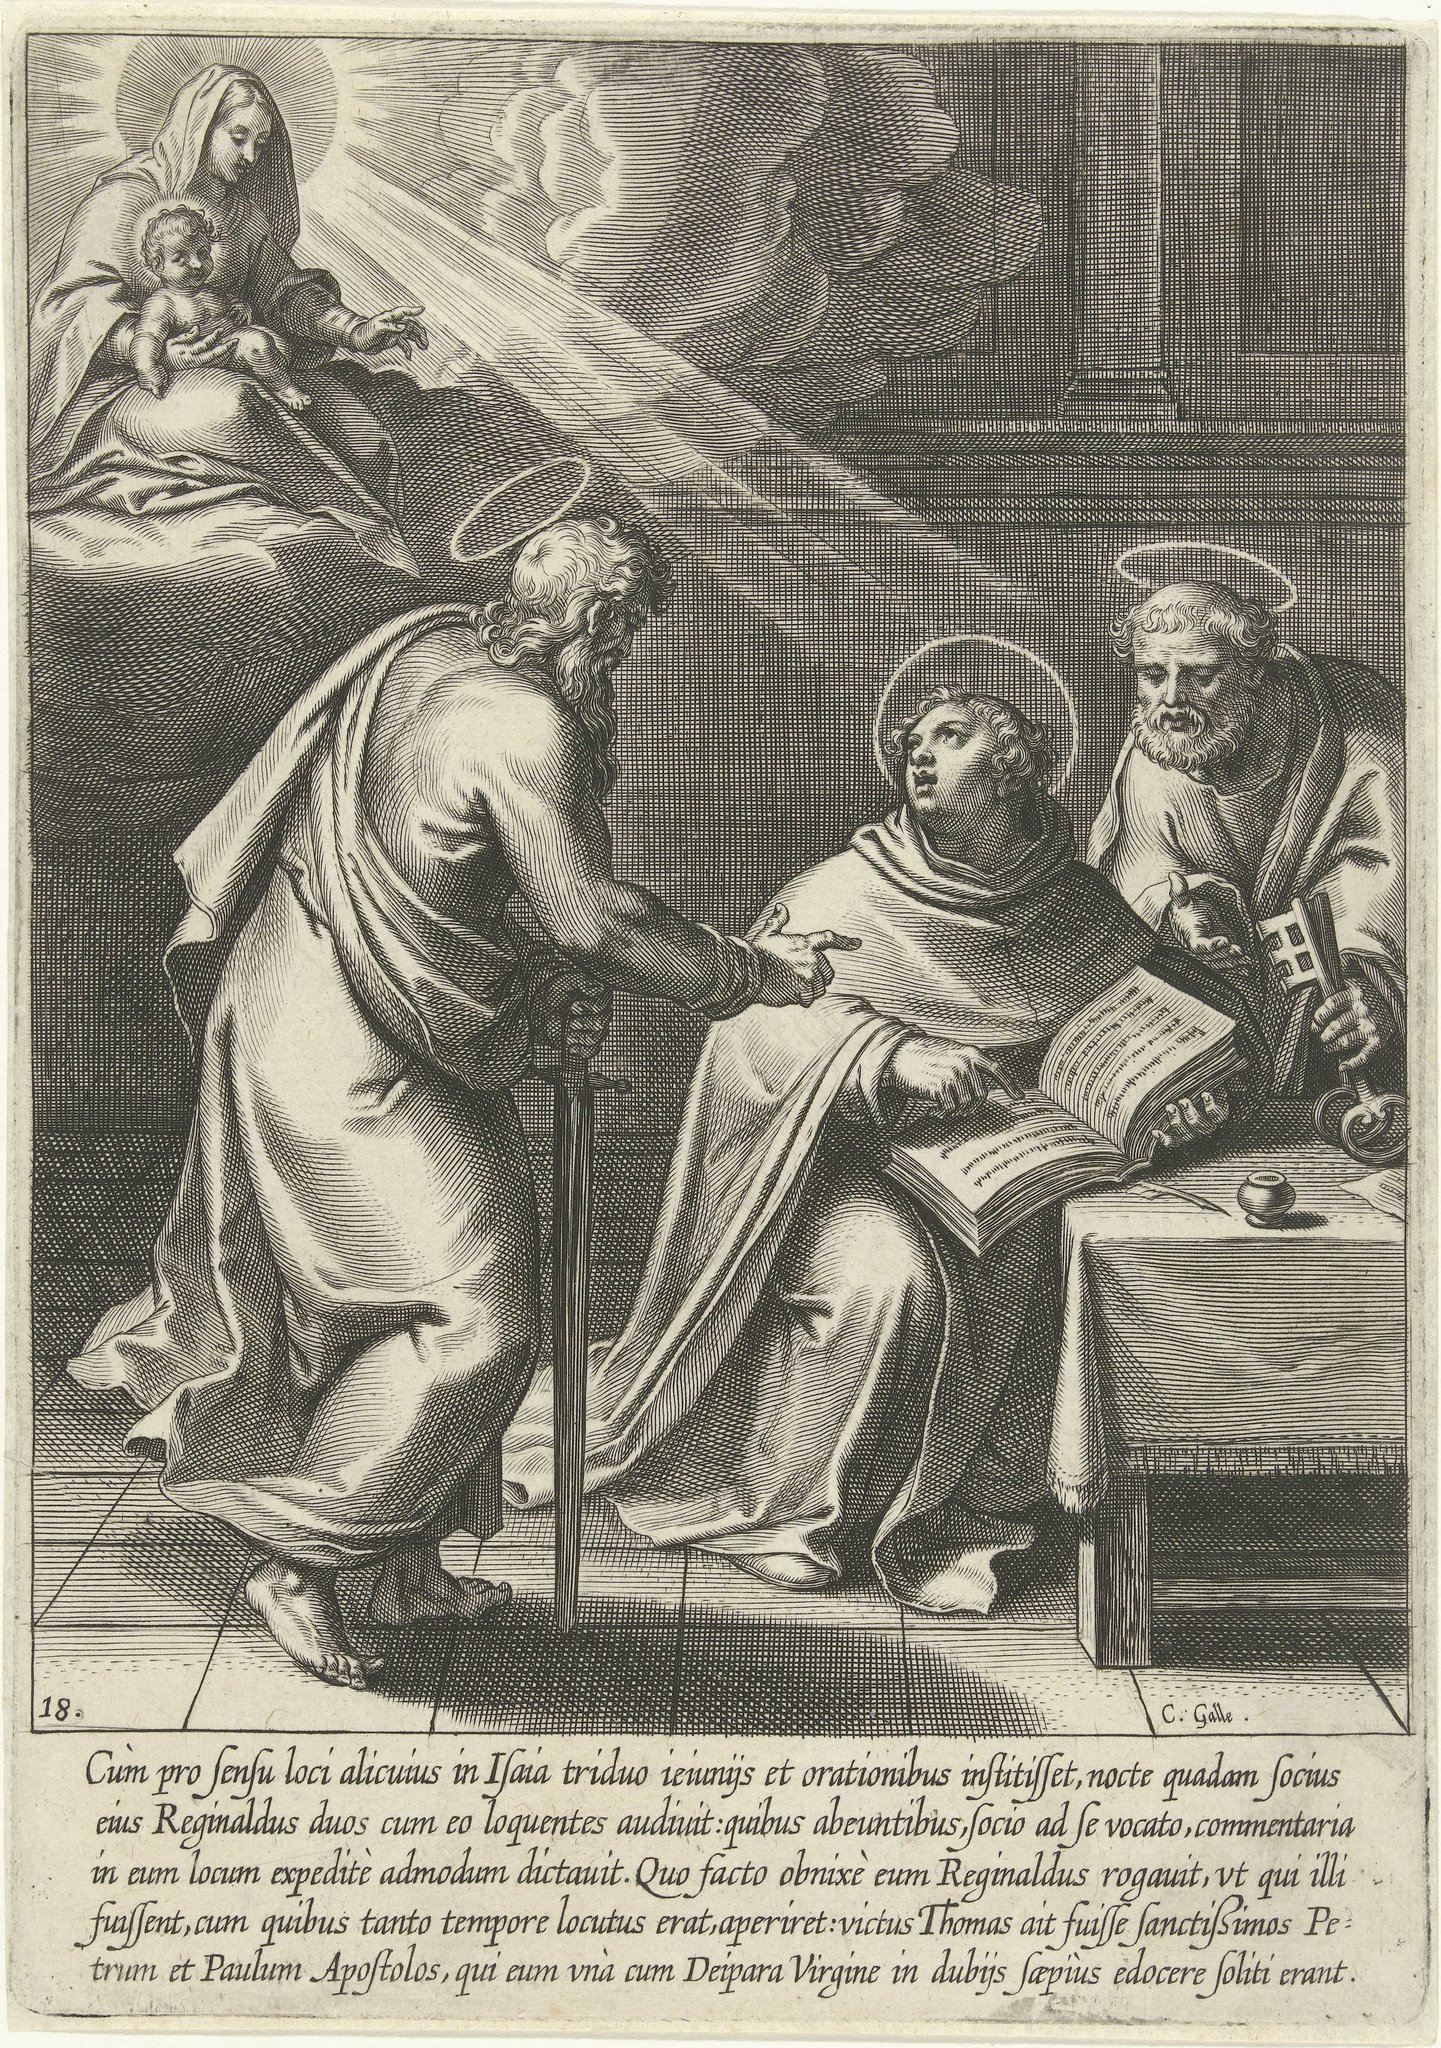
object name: print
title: Thomas door Petrus en Paulus onderwezen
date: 1610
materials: paper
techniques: engraving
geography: southern netherlands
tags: thomas van aquino, peter and paul appear to st. thomas aquinas in his study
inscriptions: collector's mark: Lugt 2228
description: Thomas van Aquino wordt in zijn studeerkamer verrast door Petrus en Paulus. Hij heeft een visioen van Maria met het Kind. Prent uit een serie van 30 prenten die het levensverhaal van Thomas van Aquino verbeelden. De prenten, naar ontwerp van en uitgegeven door Otto van Veen, zijn door C. Boel, E. van Paenderen, C. Galle en G. Swanenburgh vervaardigd.